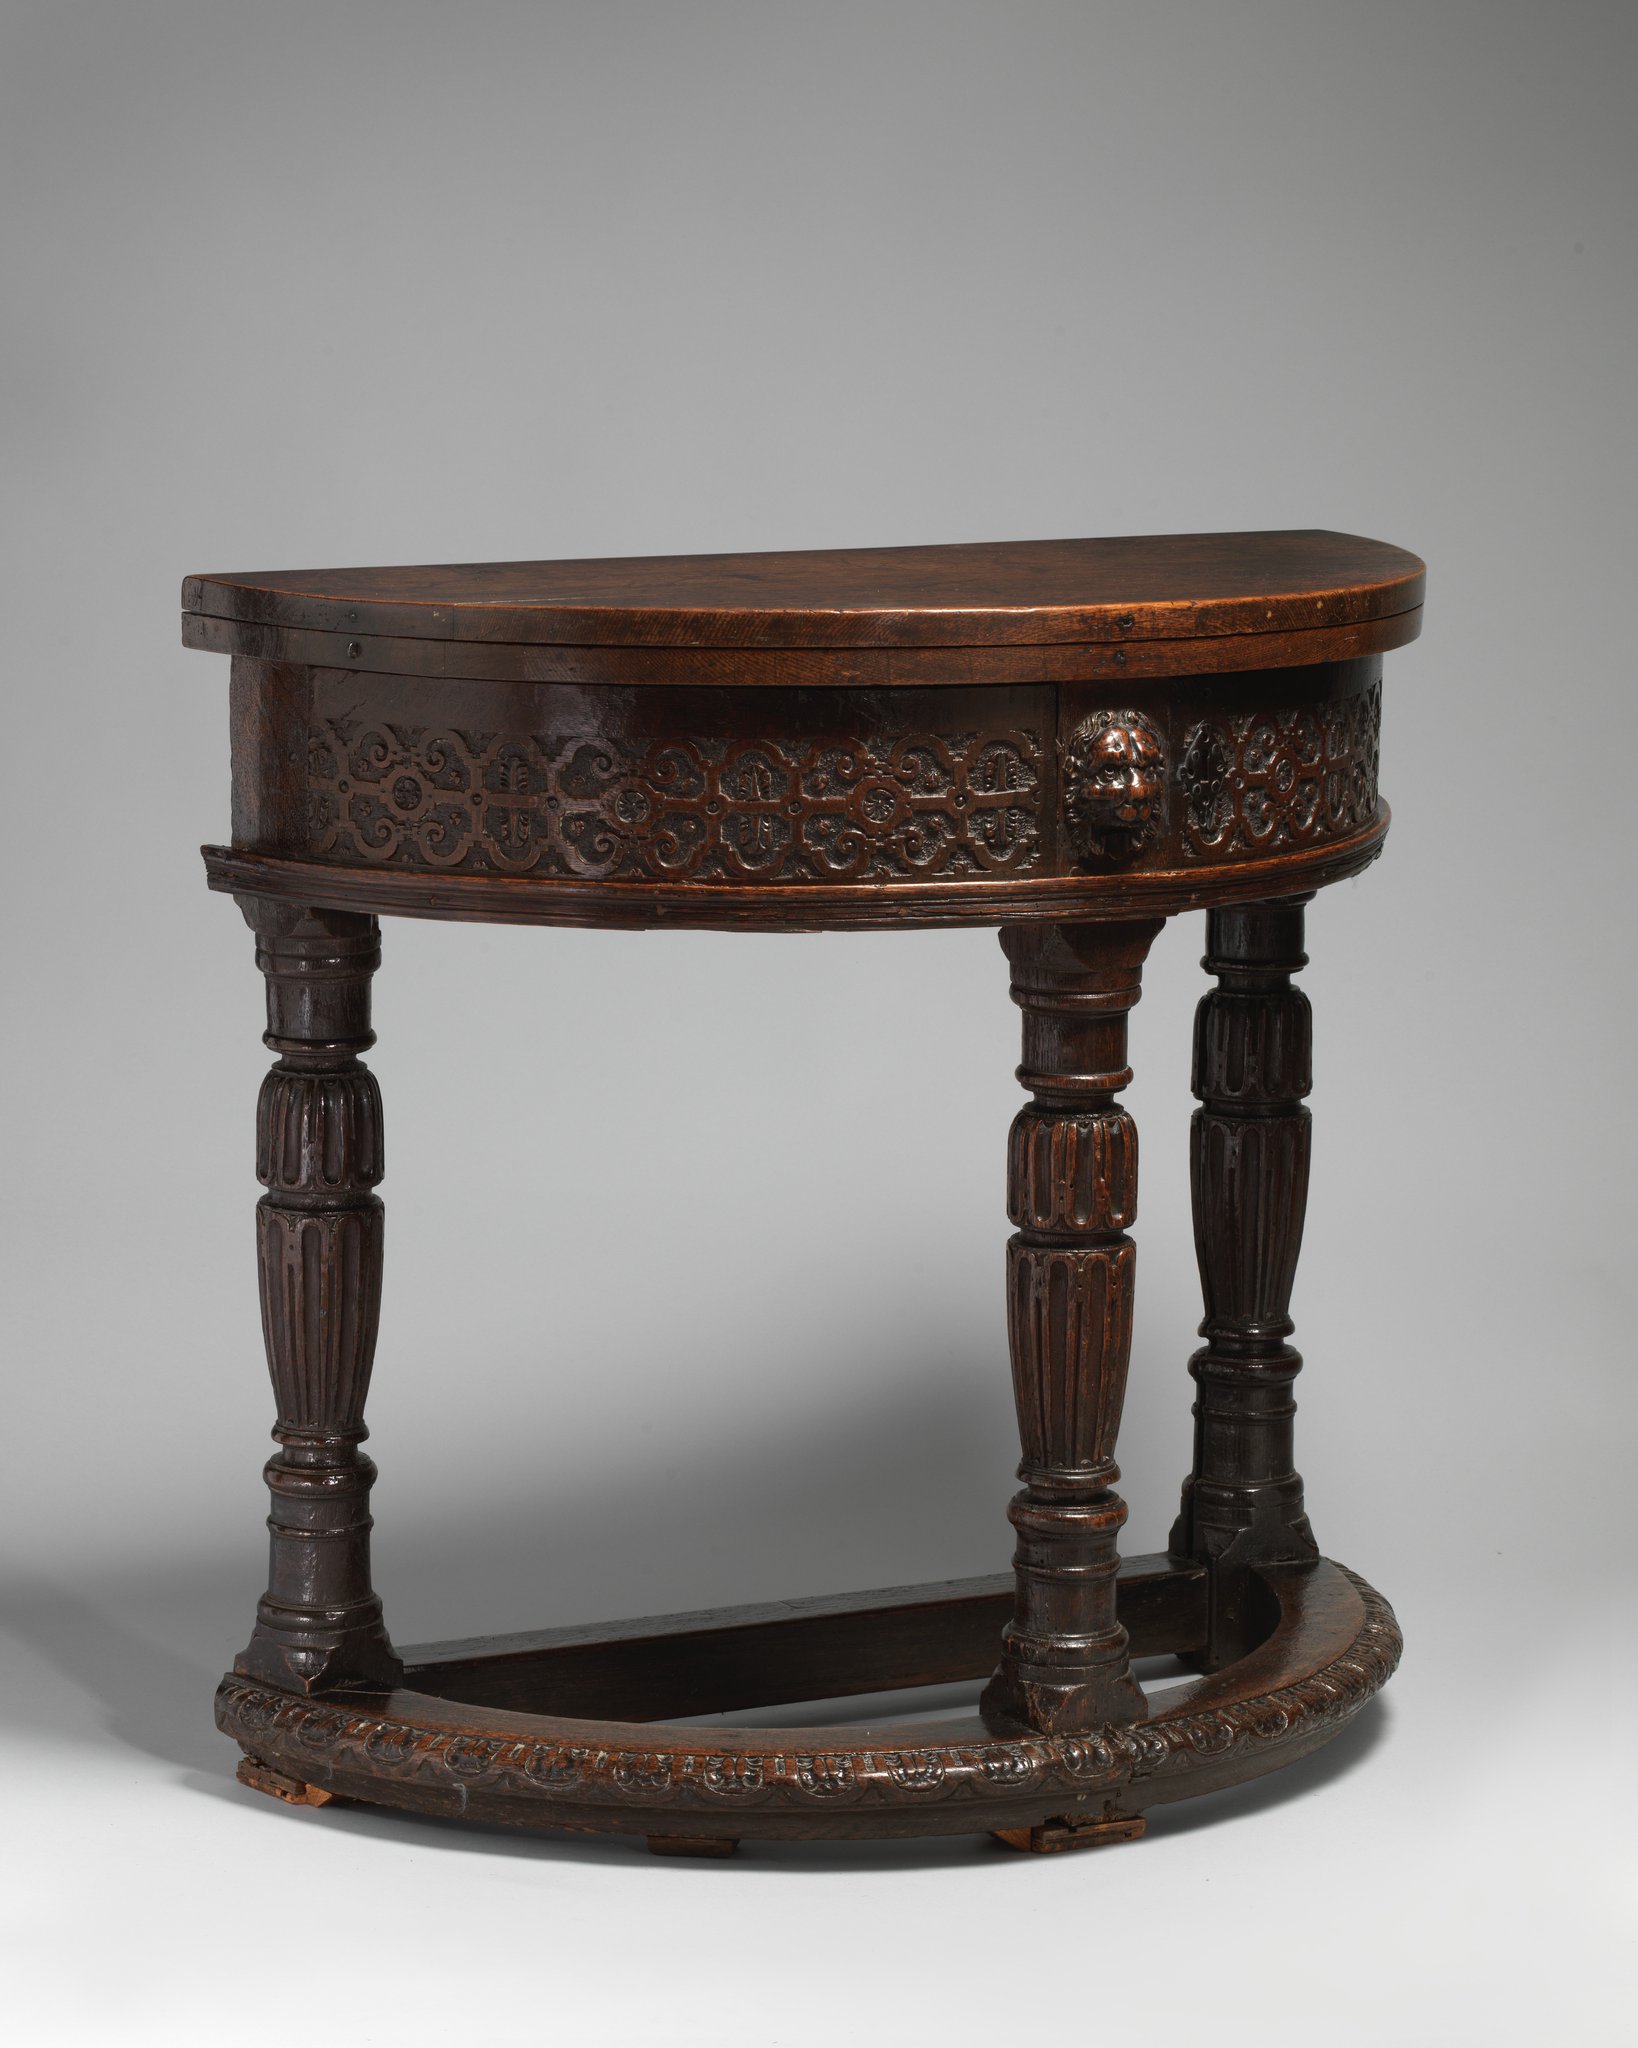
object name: table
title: Folding table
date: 1600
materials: wood